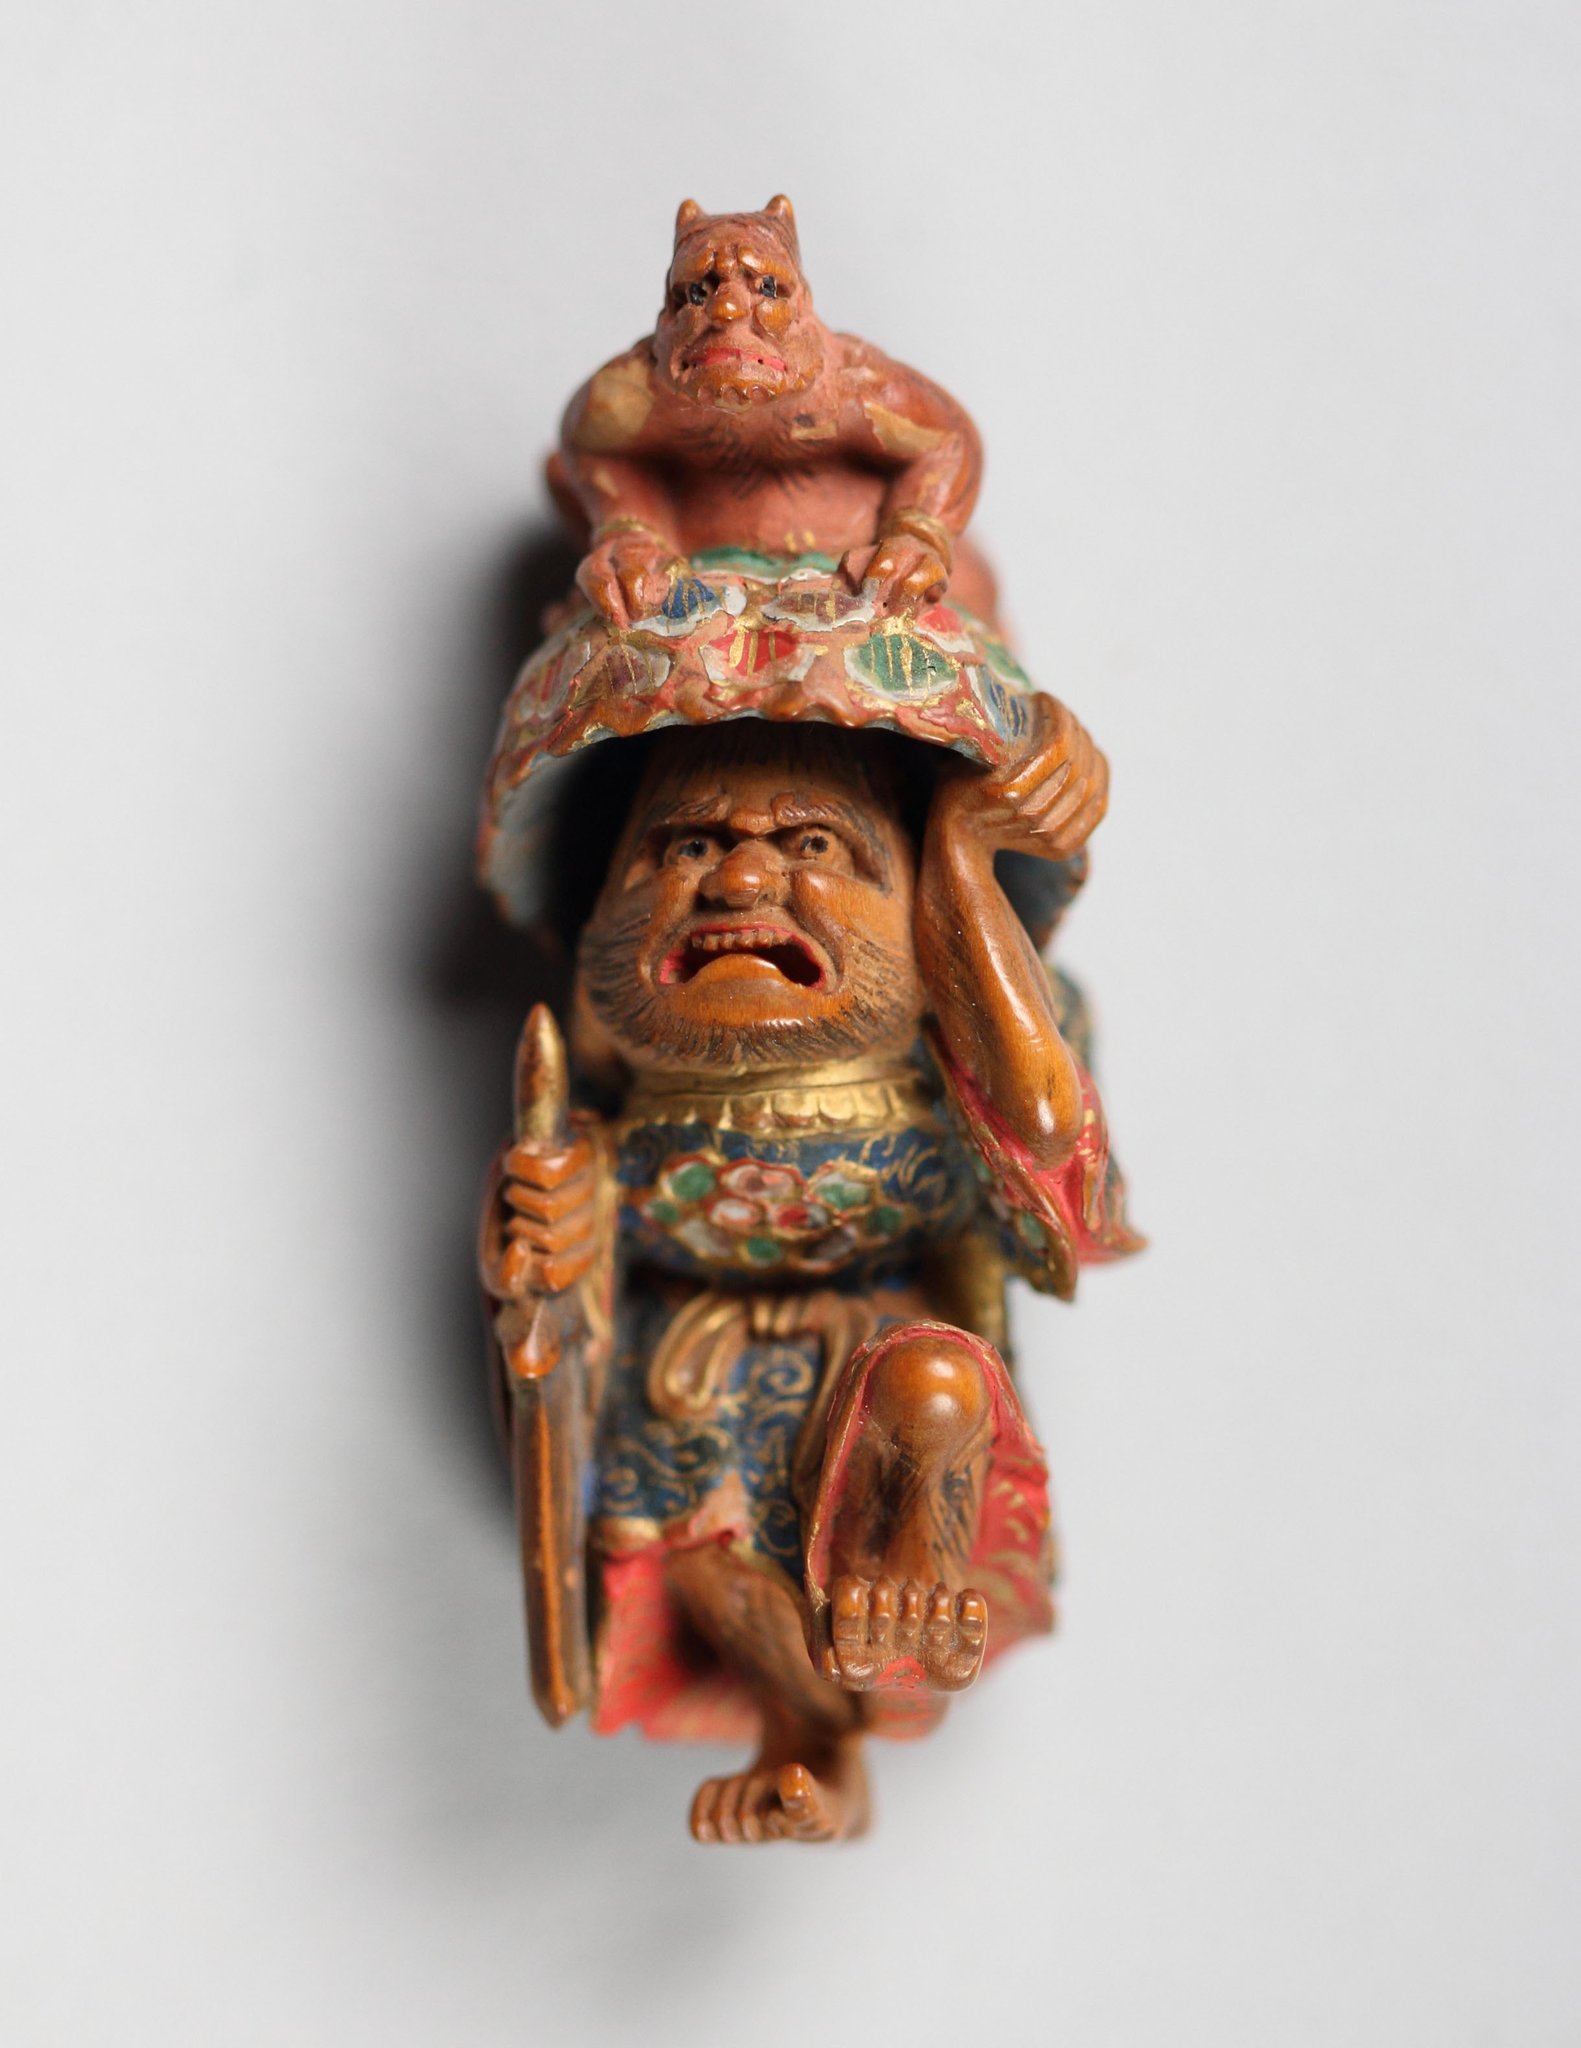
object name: netsuke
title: Netsuke of Man with an Ōni on His Hat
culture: japanese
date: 1801-1900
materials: wood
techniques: lacquer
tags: men,monsters